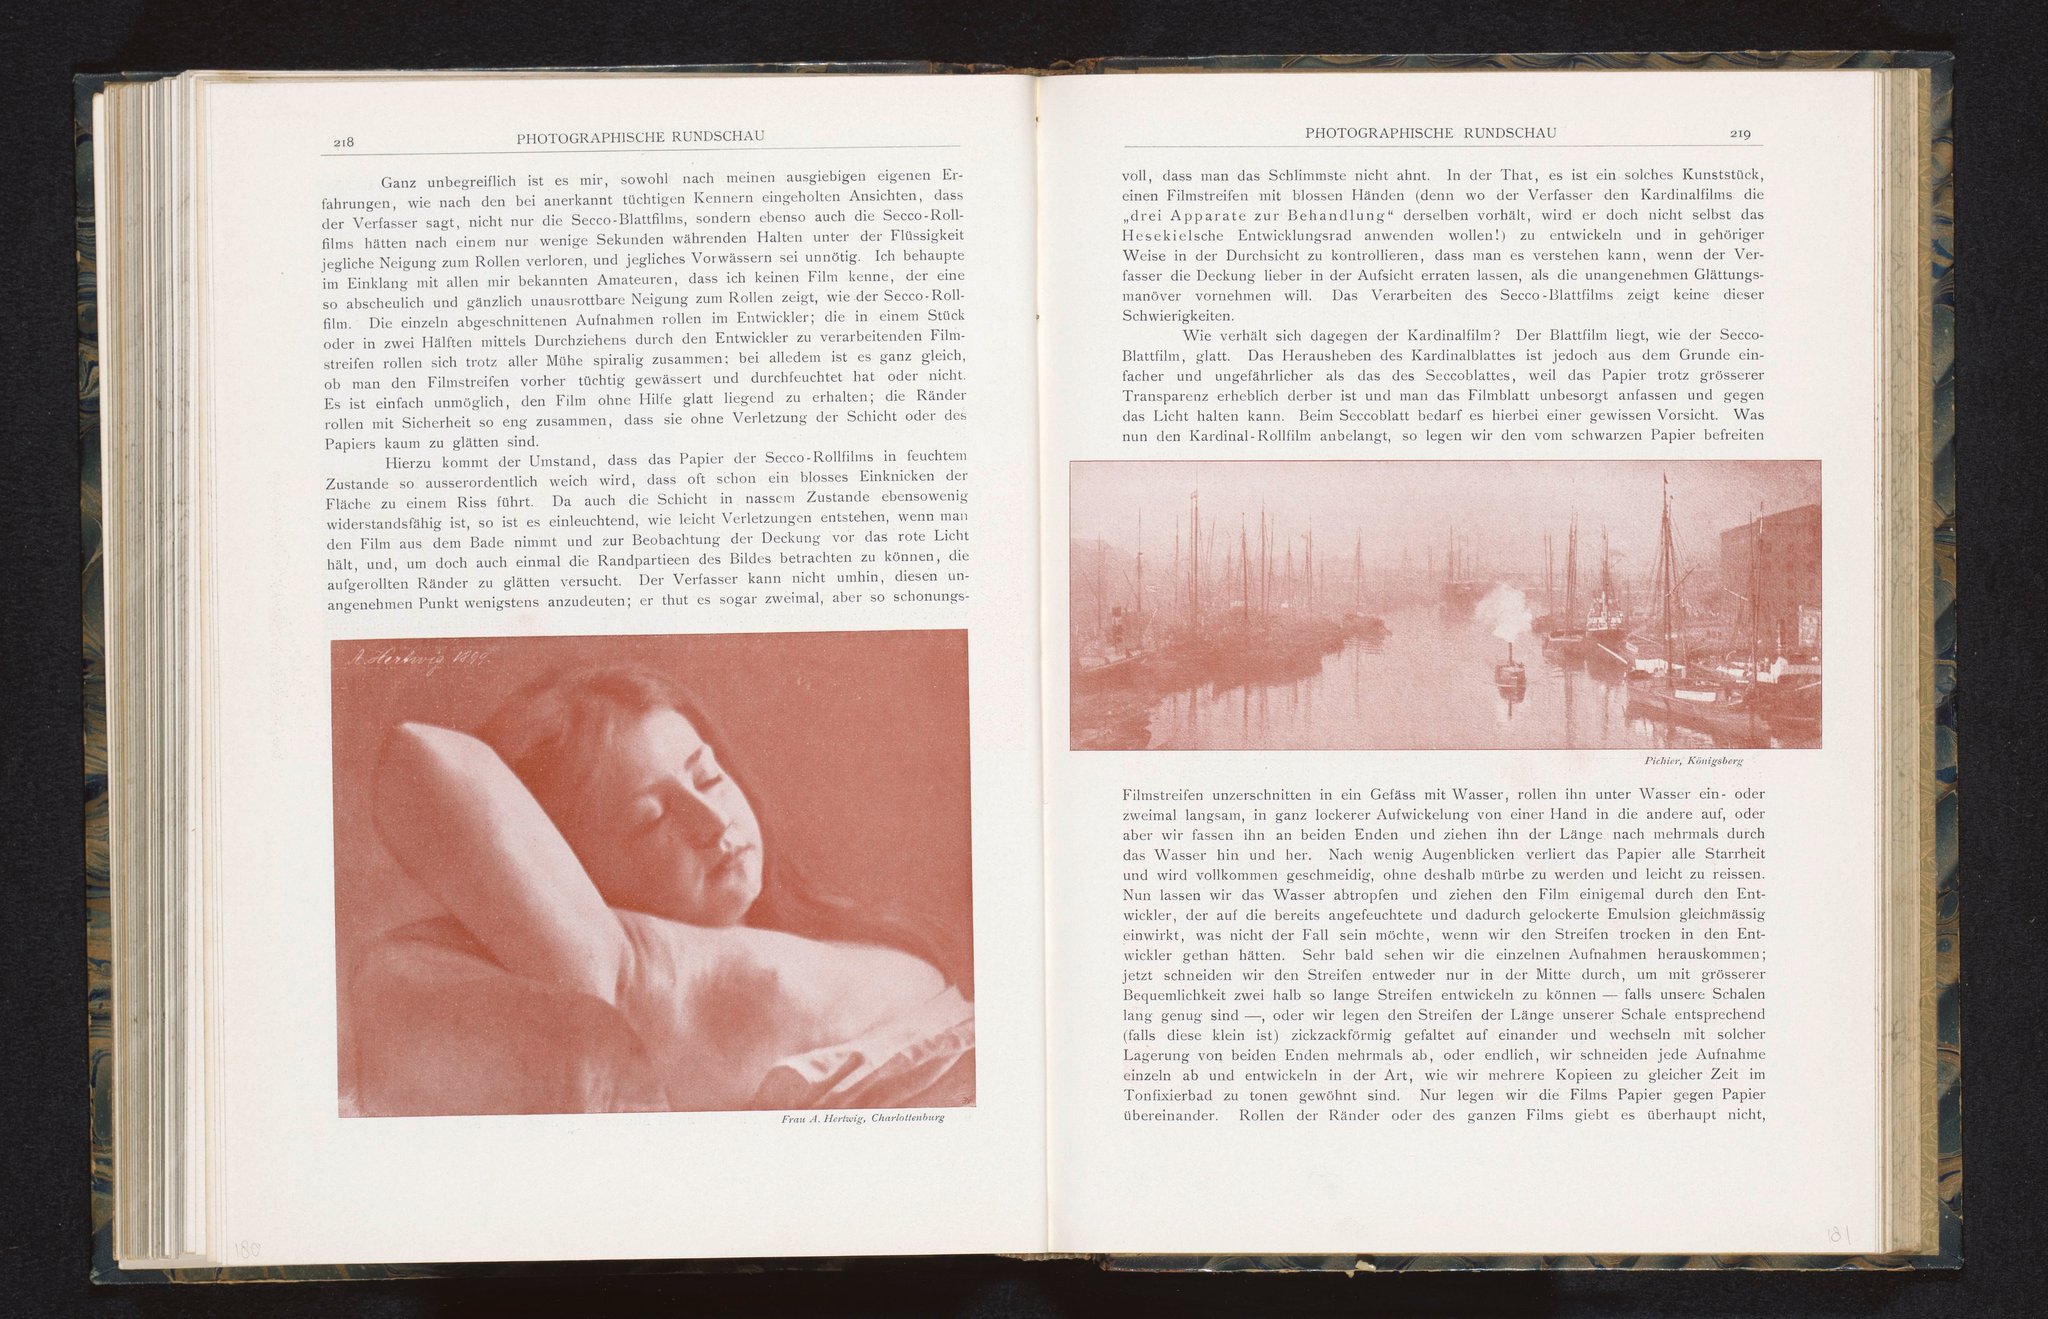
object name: photomechanical print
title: Gezicht op een haven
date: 1895-1900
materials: paper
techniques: autotype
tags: harbour, sailing-ship, sailing-boat, steamship, motorship